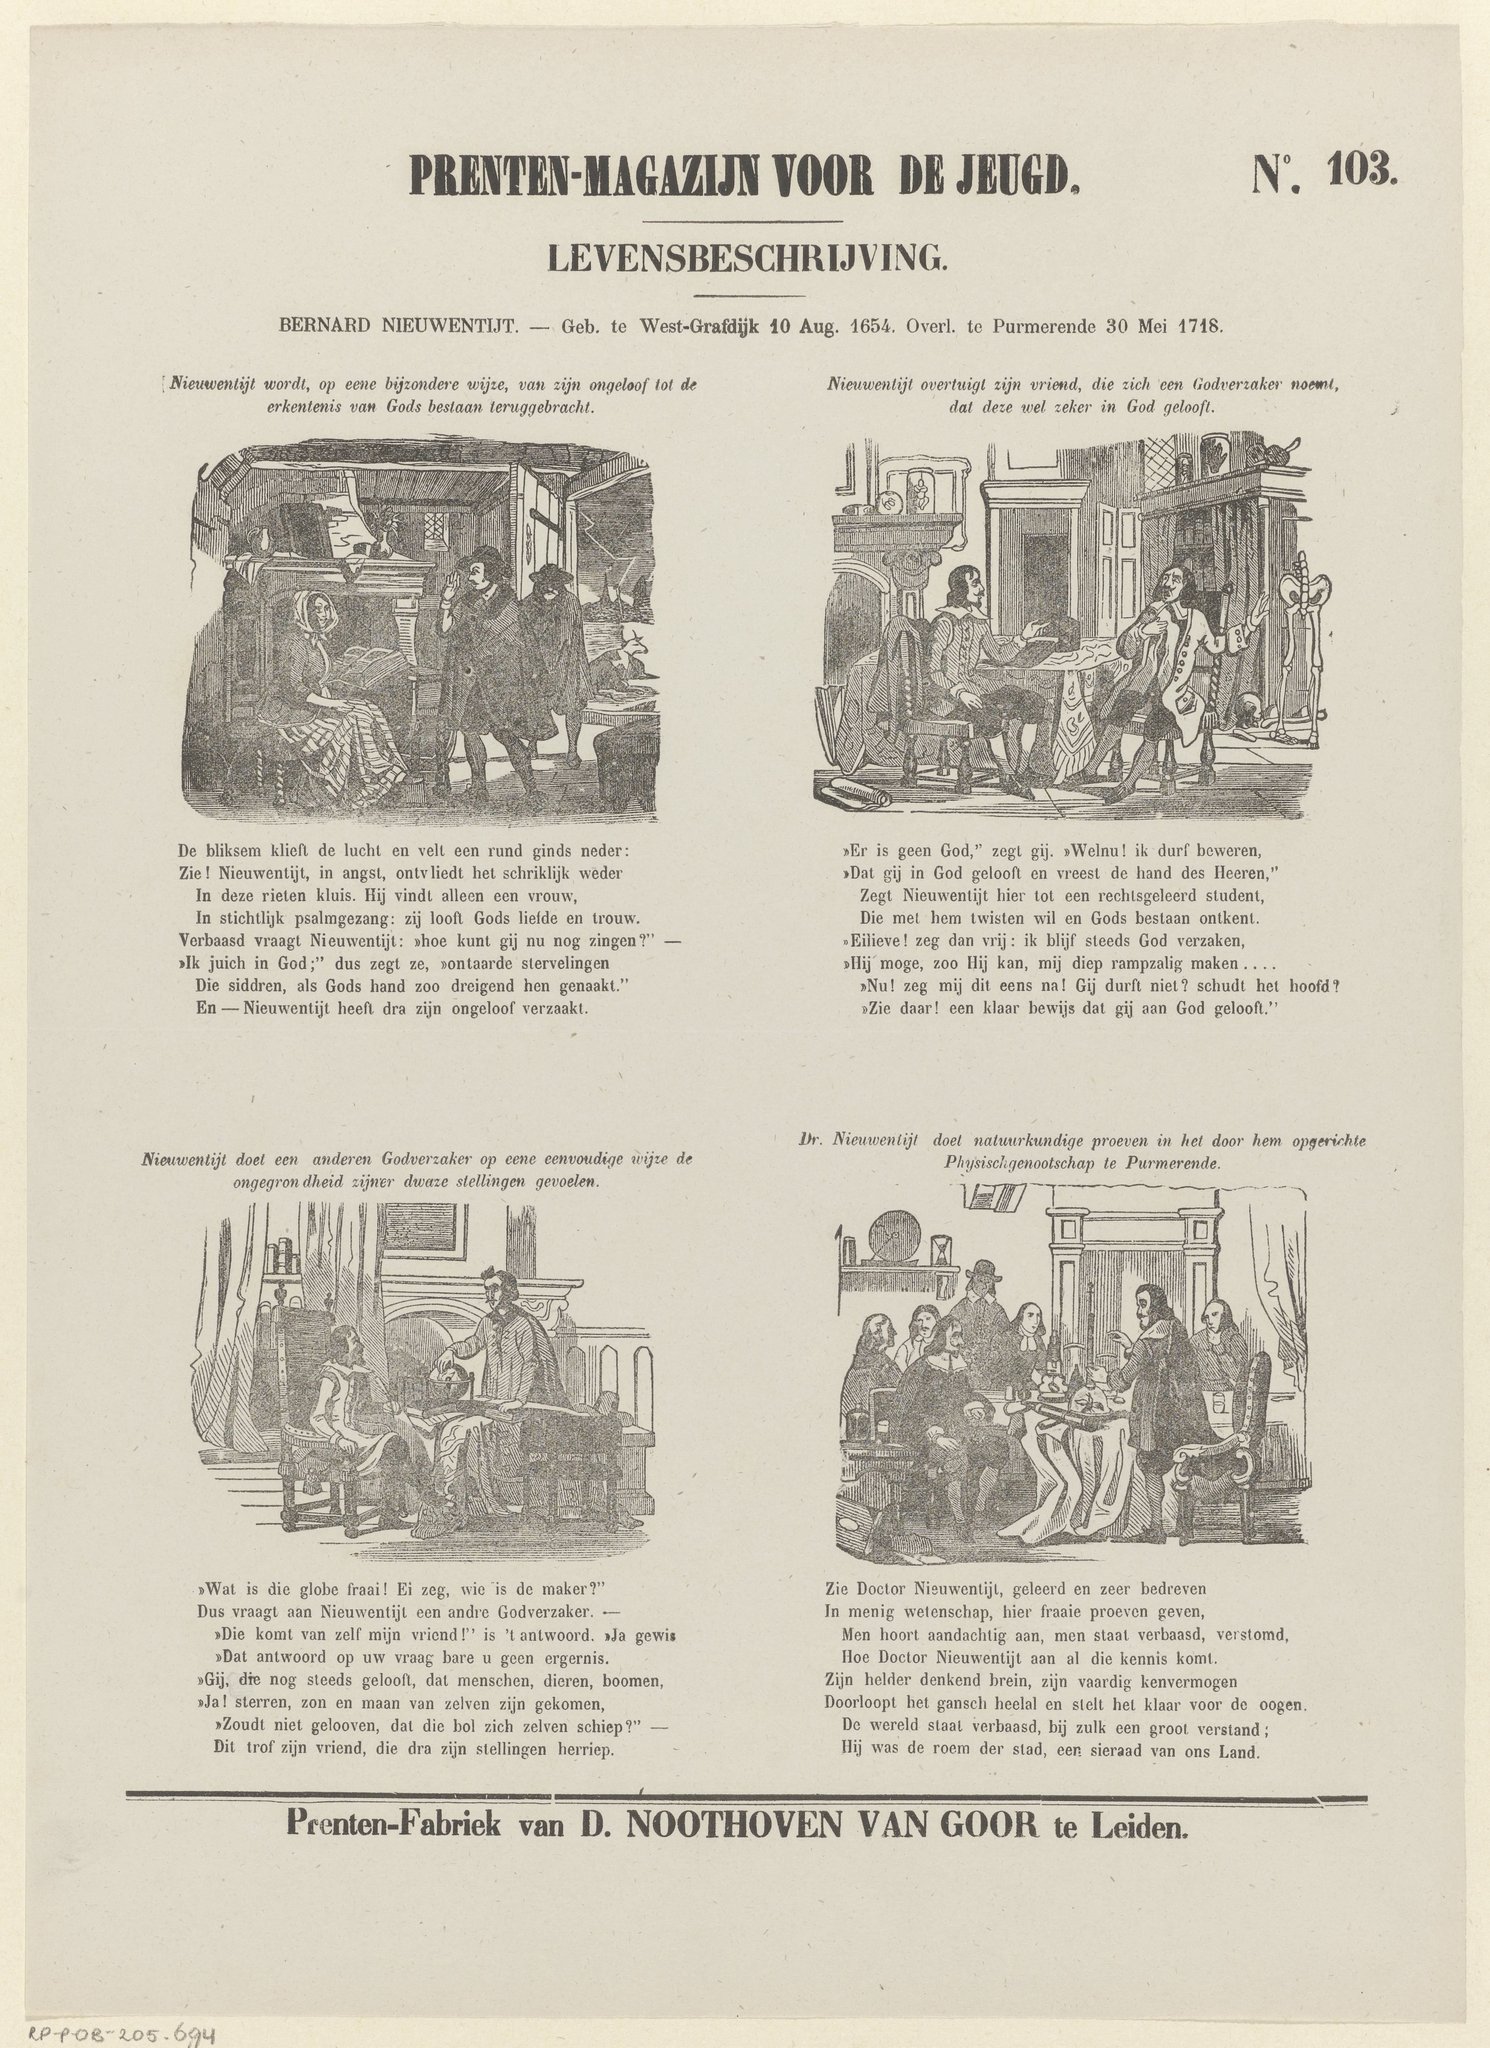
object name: popular print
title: Levensbeschrijving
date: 1850-1881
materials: paper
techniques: letterpress printing, engraving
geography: netherlands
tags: west-graftdijk, wiskundige, bernard nieuwentijt, purmerend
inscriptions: collector's mark: Lugt 2760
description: Blad met 4 voorstellingen uit het leven van Bernard Nieuwentijt. Boven elke voorstelling een titel en onder elke voorstelling een achtregelig vers. Genummerd rechtsboven: No. 103.